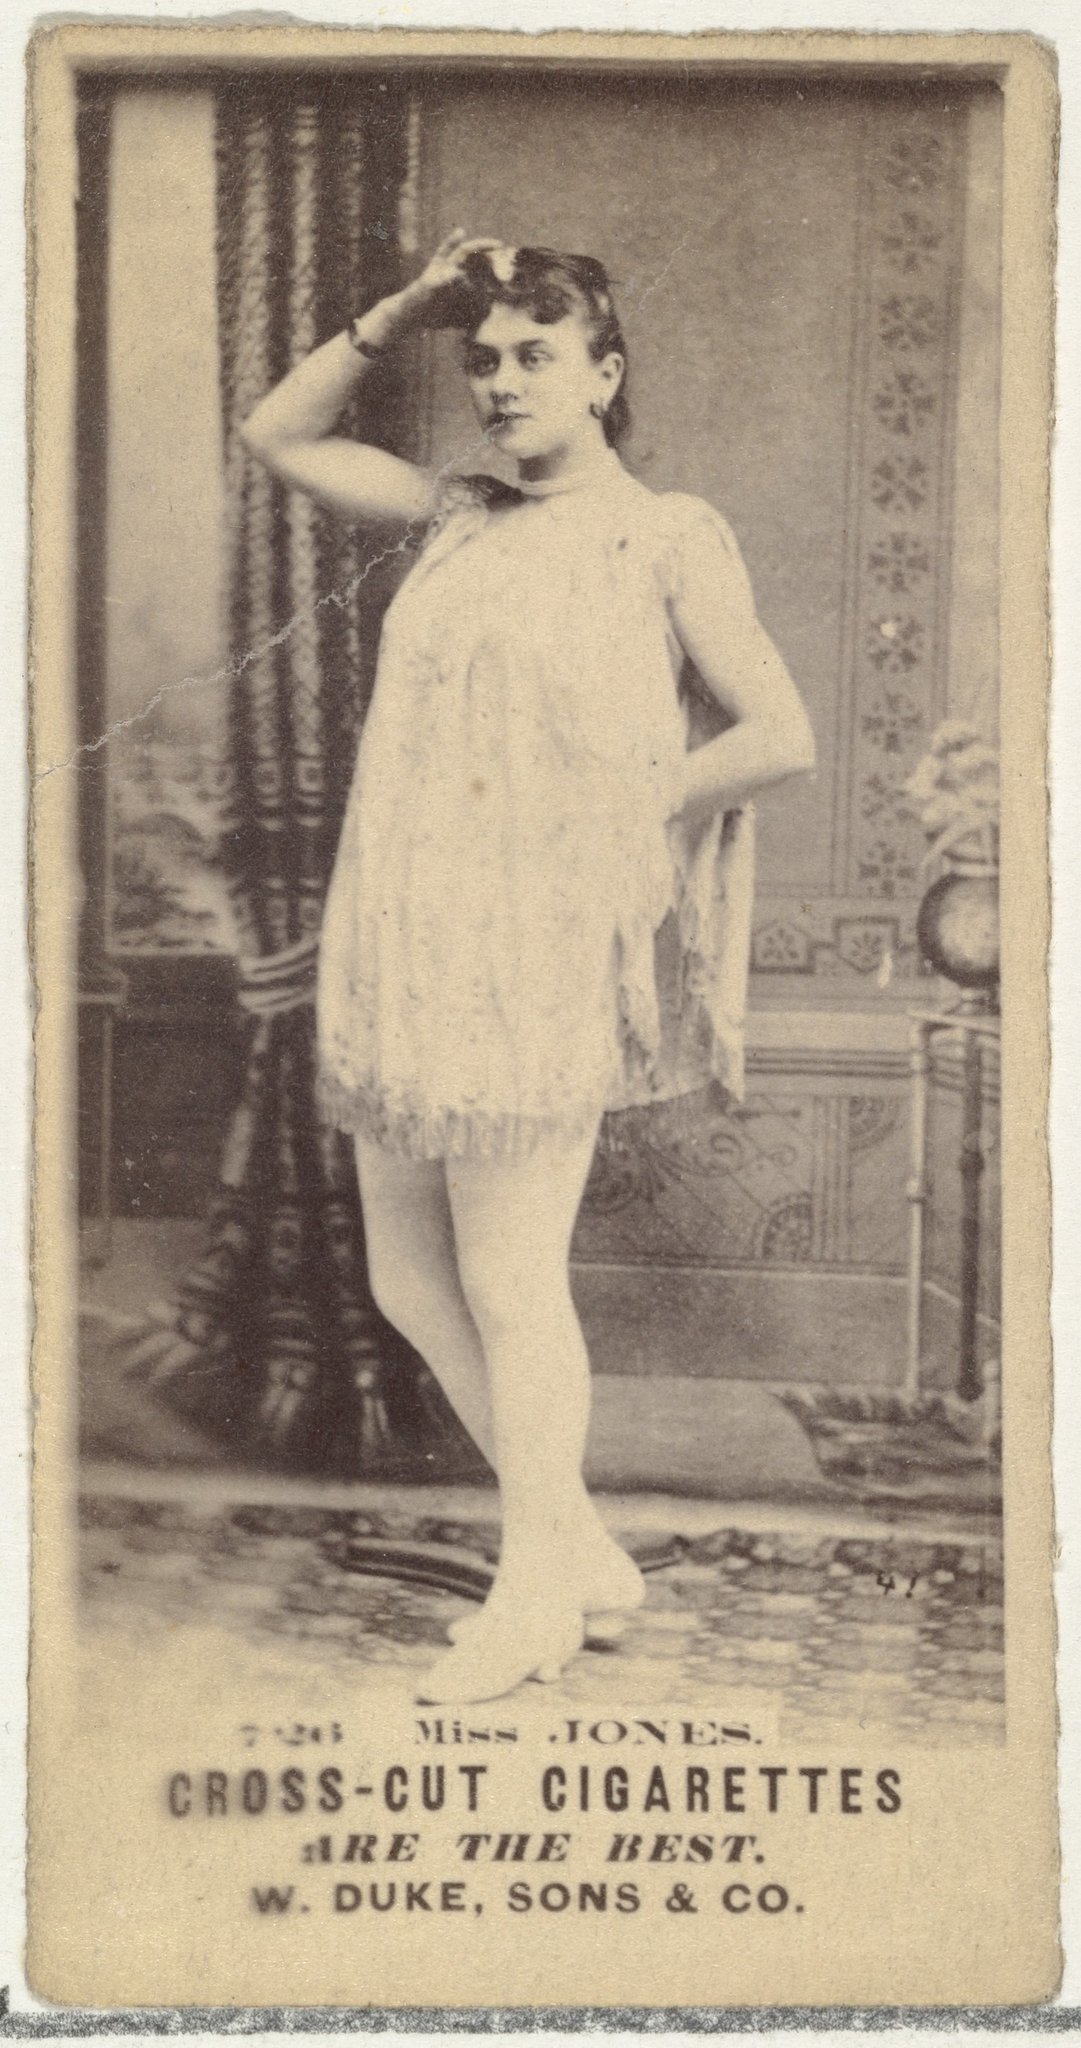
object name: photograph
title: Card Number 726, Miss Jones, from the Actors and Actresses series (N145-3) issued by Duke Sons & Co. to promote Cross Cut Cigarettes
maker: w. duke, sons & co.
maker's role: publisher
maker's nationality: american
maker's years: 1870-1920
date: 1880-1889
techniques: albumen silver print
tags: portraits,women,actresses